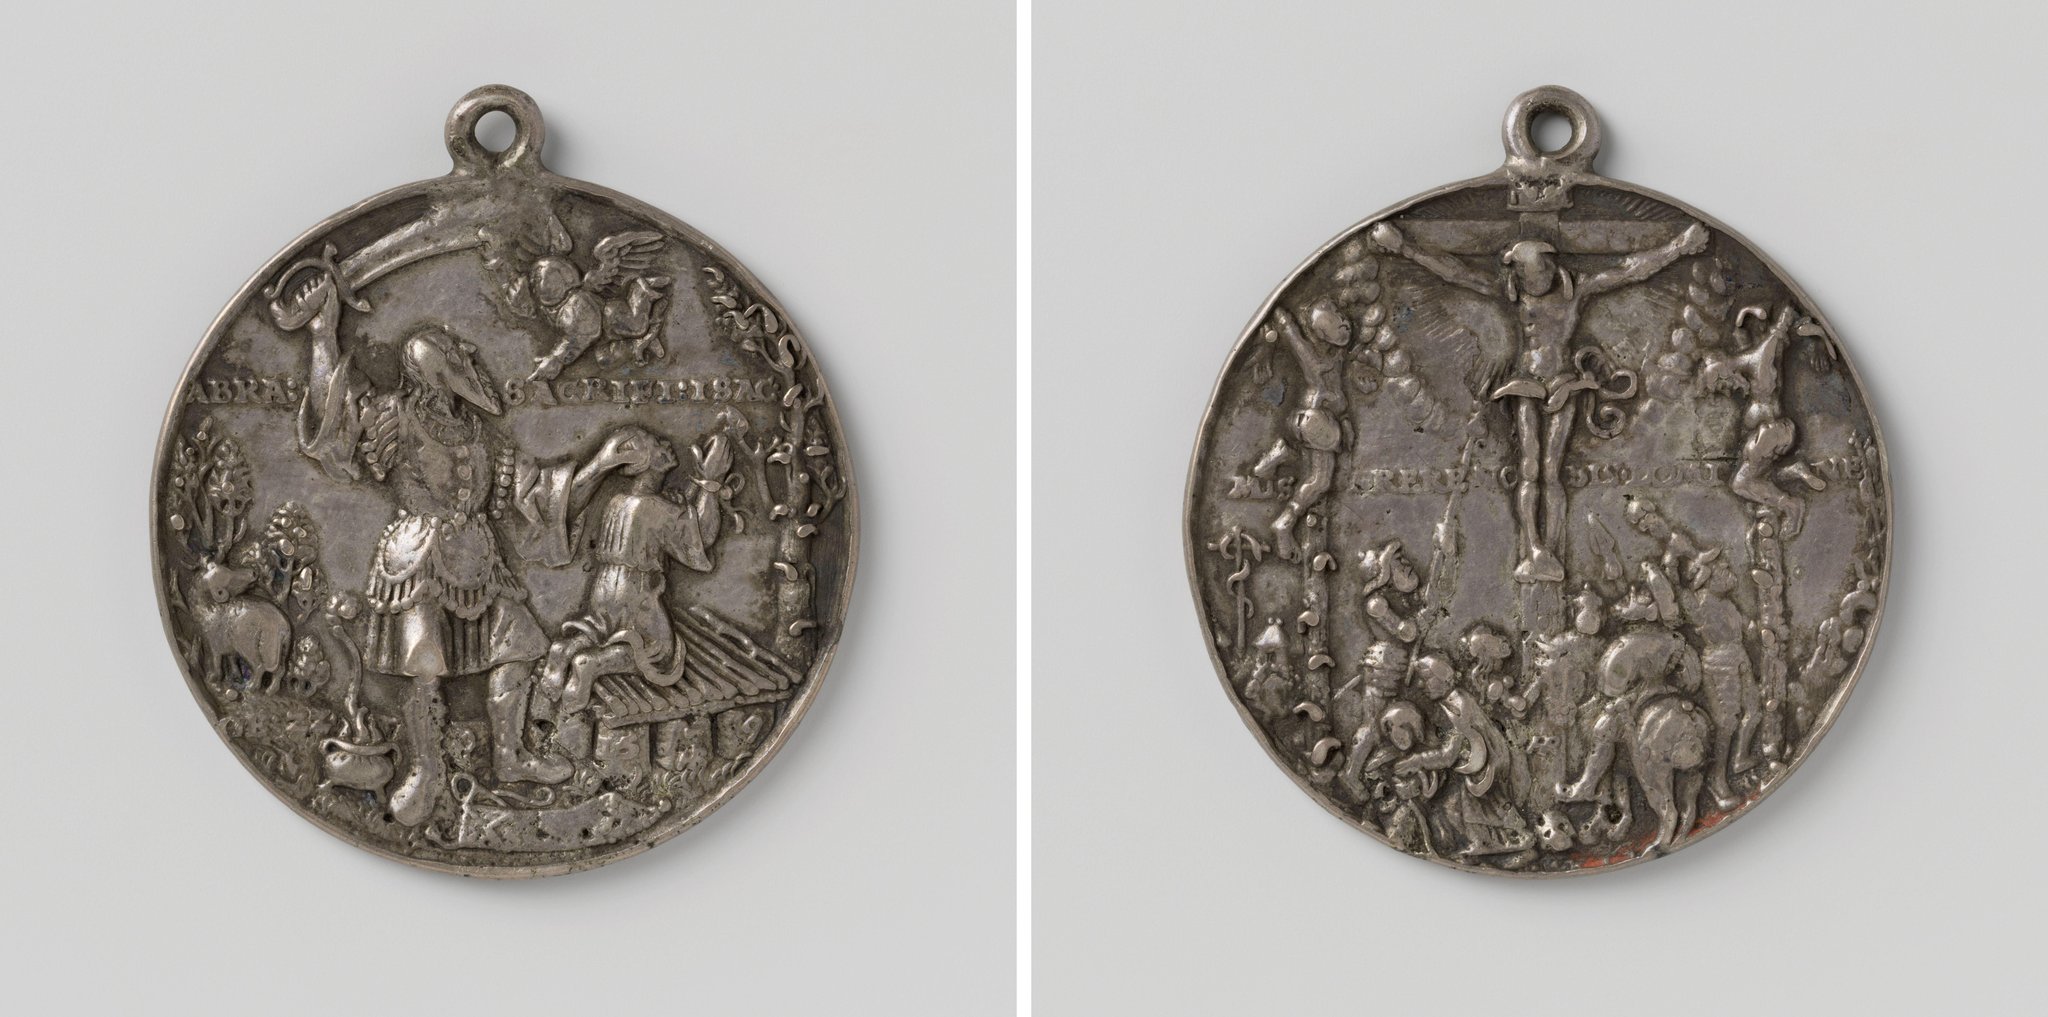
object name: history medal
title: Offer van Isaak en kruisiging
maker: hans reinhart (der ältere)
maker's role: medailleur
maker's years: 1510-1581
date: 1539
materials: silver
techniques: casting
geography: leipzig